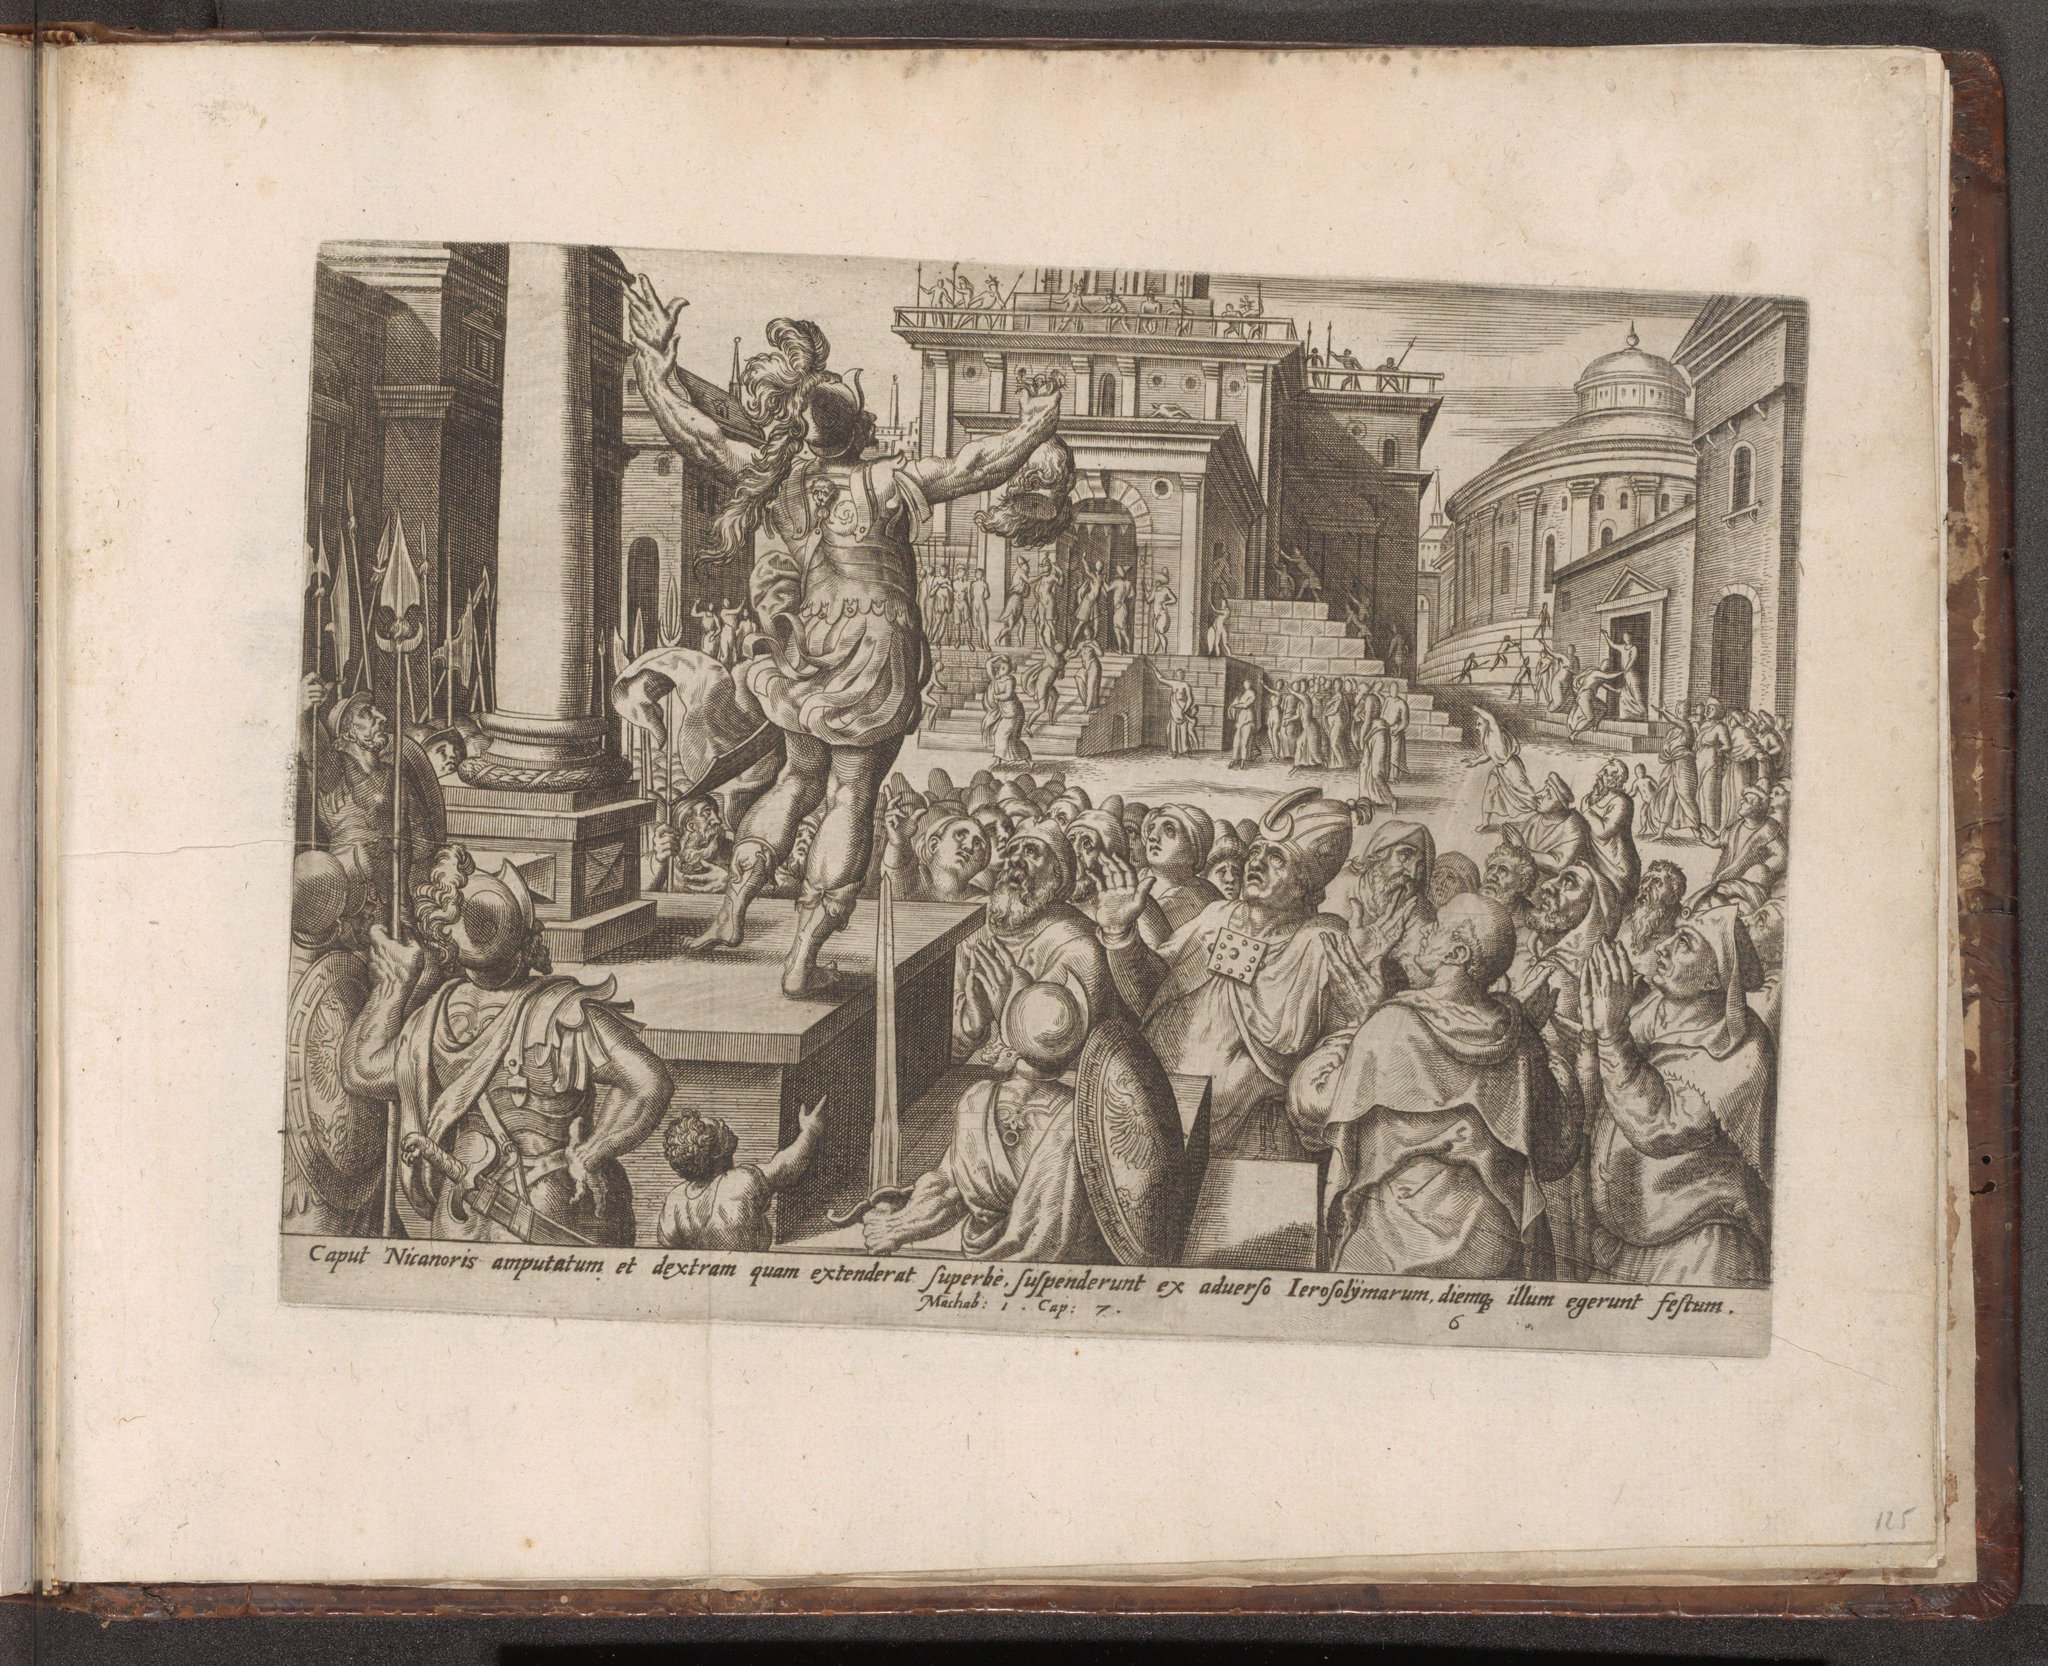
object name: print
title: Thesaurus sacrarum historiaru[m] veteris testame[n]ti, elega[n]tissimis imaginibus expressu[m] excelle[n]tissimoru[m] in hac arte viroru[m] opera: nu[n]c primu[m] in luce[m] editus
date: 1579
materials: paper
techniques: engraving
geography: antwerp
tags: nicanor's head and hand hung near jerusalem (+ variant)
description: Het afgehakte hoofd en de hand van Nikanor worden in Jeruzalem aan het volk getoond. Nikanor wilde Israël uitroeien, maar de Israëlieten overwonnen hem en zijn leger. Onder de voorstelling een verwijzing in het Latijn naar de Bijbeltekst in 1 Makk. 7:27. Prent maakt deel uit van een album.